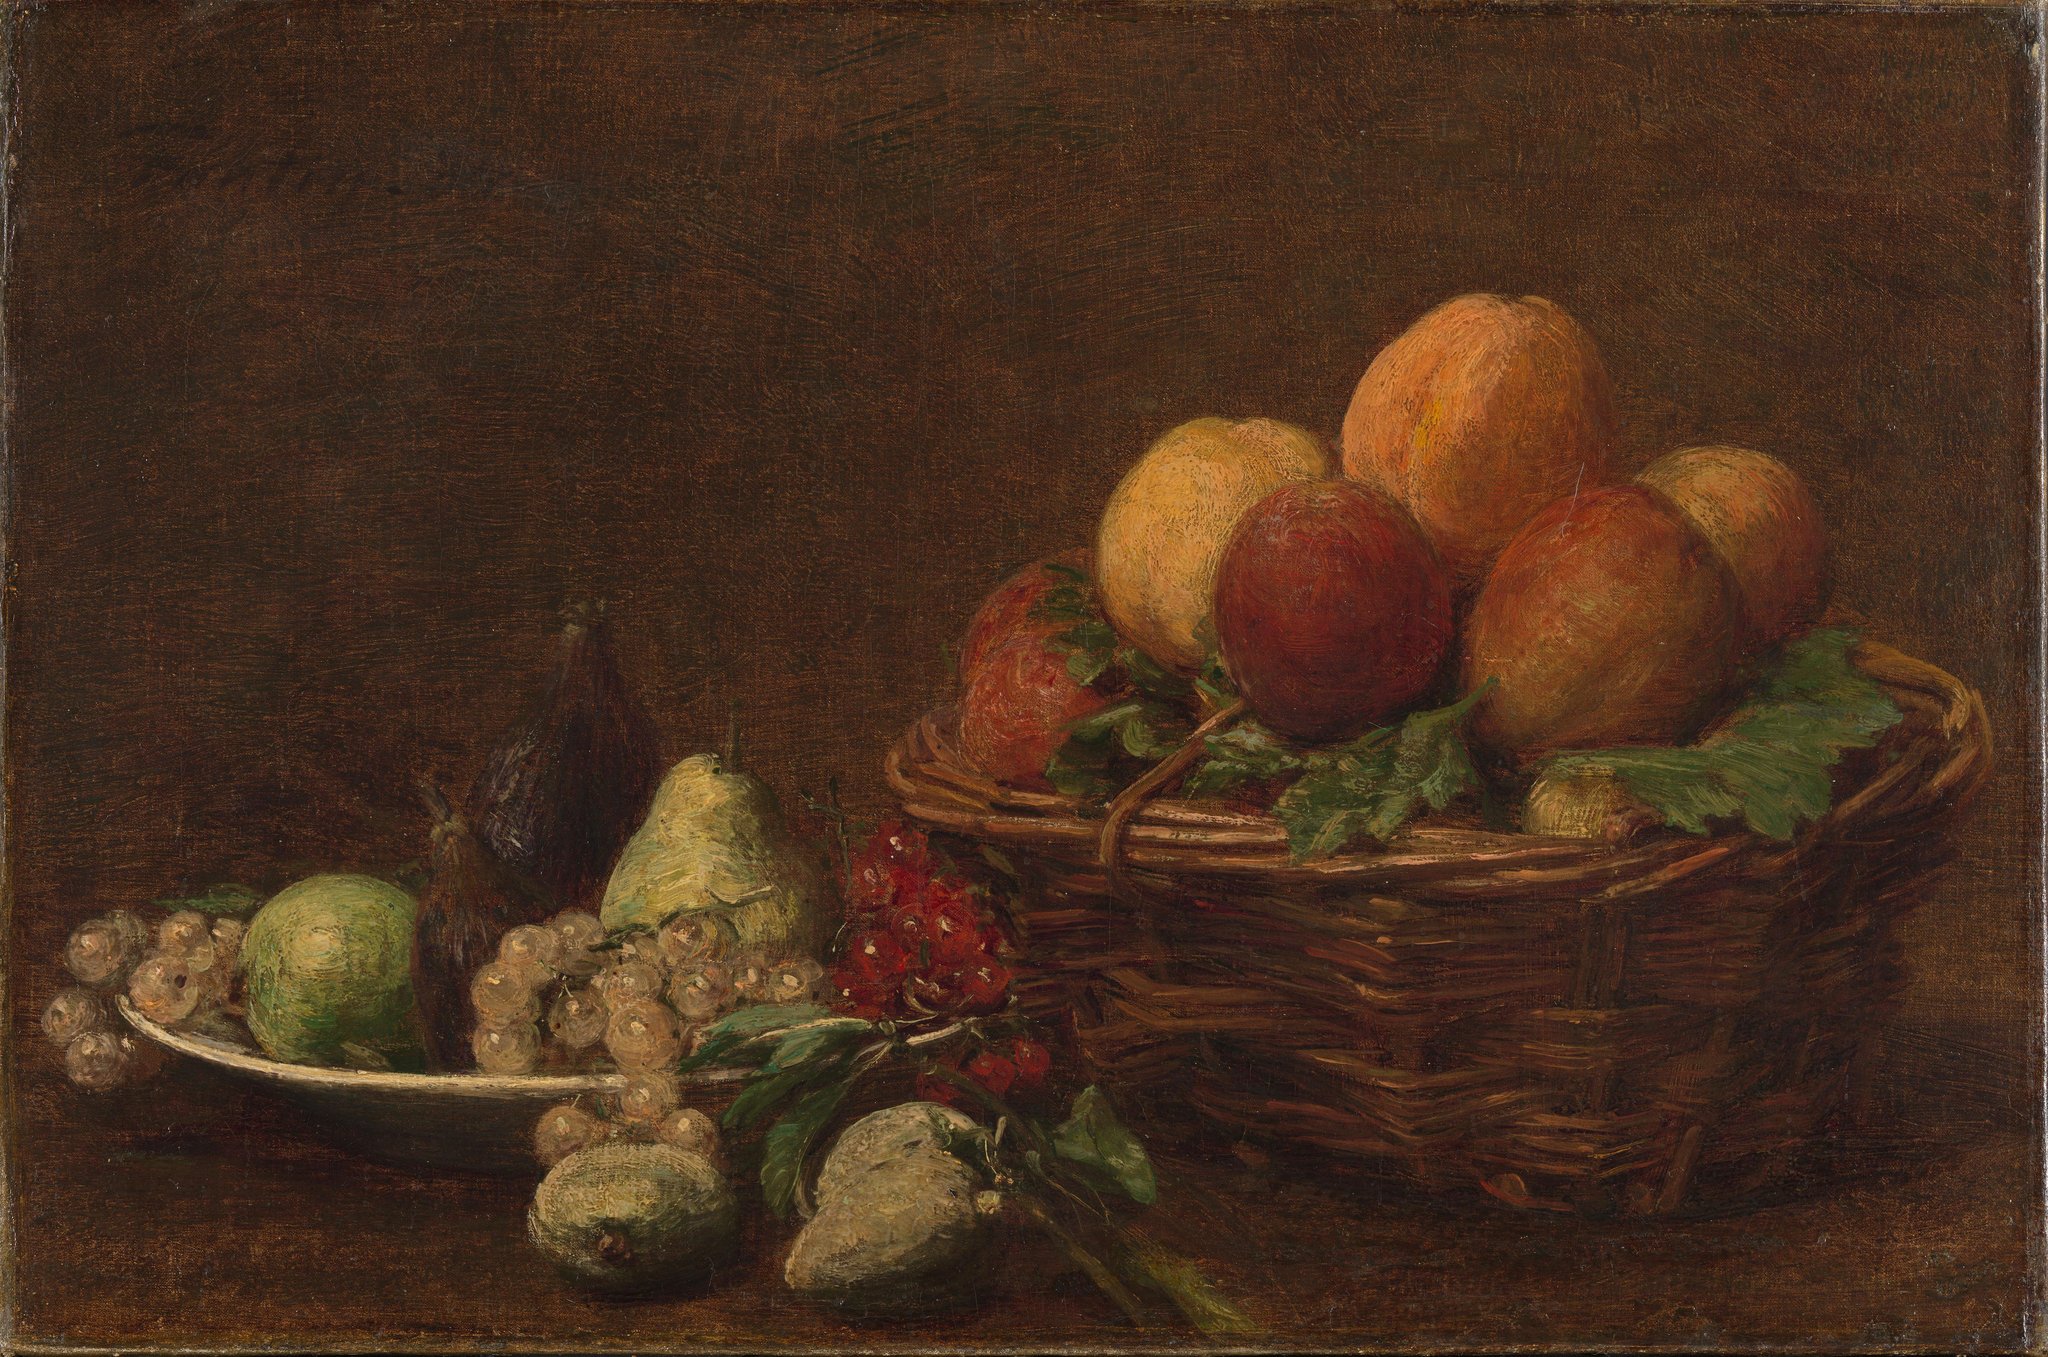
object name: painting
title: Still Life with Fruit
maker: henri fantin-latour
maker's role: draughtsman, print maker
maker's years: 1836-1904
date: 1880-1890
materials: canvas, oil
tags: still life of related objects, fruits, vegetables and fruit; still life of vegetables and fruit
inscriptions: signature: ‘Fantin’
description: Stilleven met fruit. Witte schotel met druiven en een peer, rechts een mandje met appels en andere vruchten.